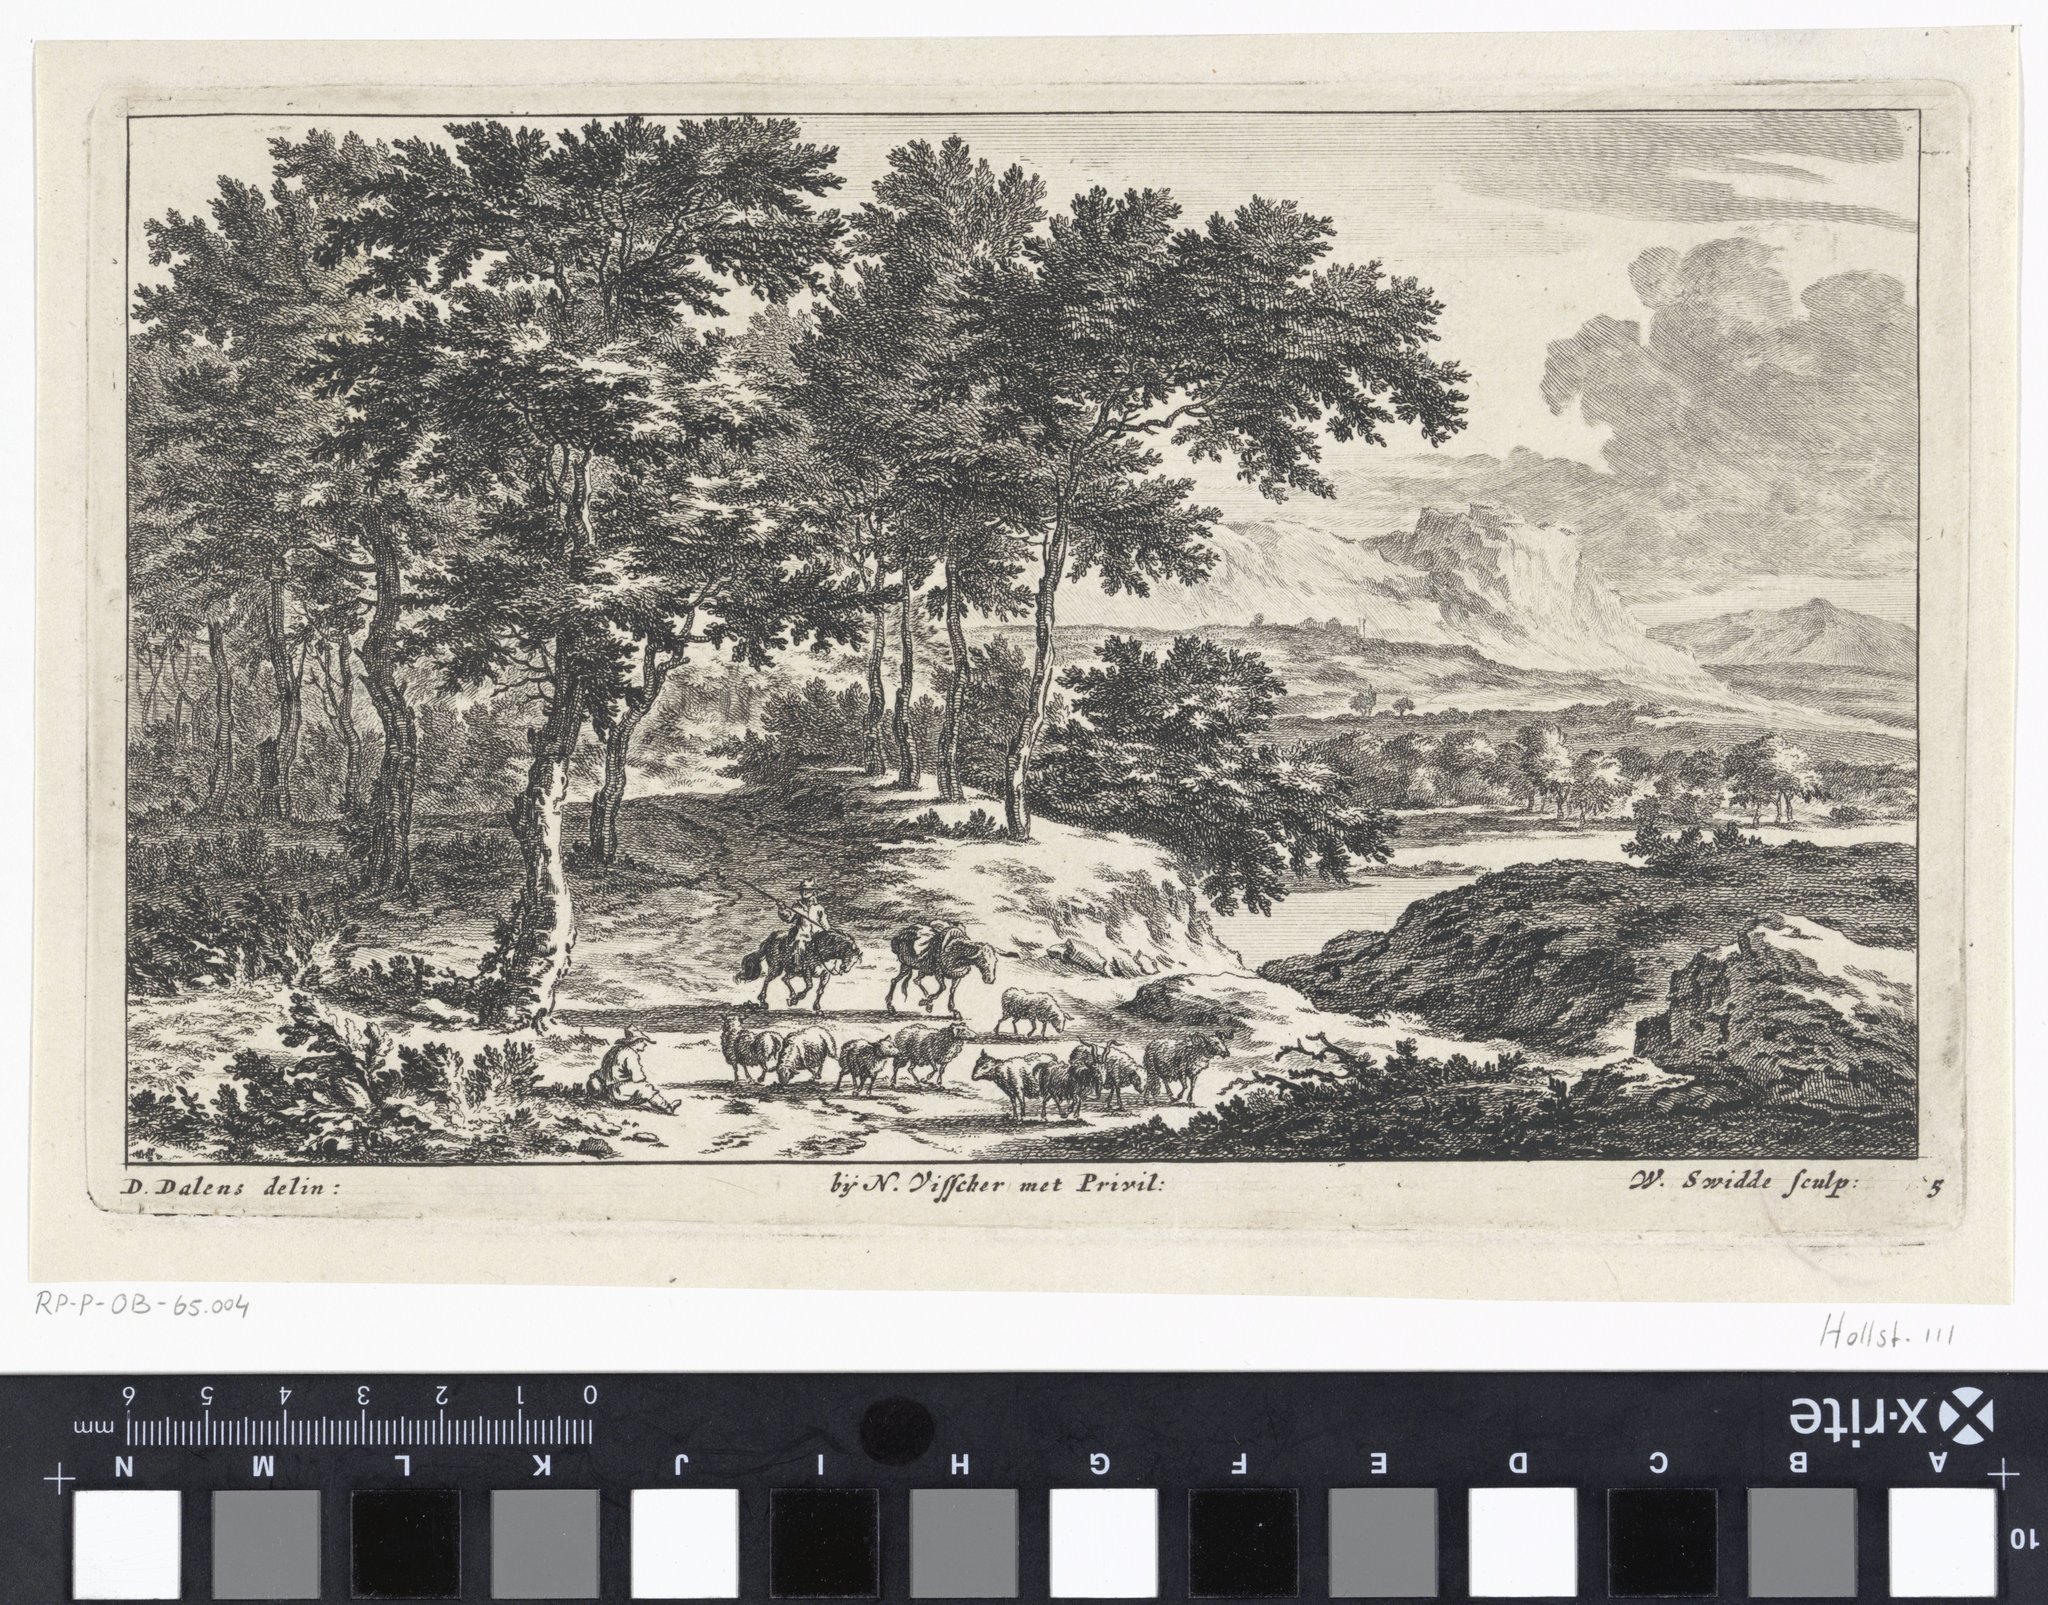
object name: print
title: Landschap met herder te paard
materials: paper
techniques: etching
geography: amsterdam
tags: river - hh - ideal landscapes, ass, donkey, herd, flock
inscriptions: collector's mark: Lugt 240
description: In een landschap met een rivier drijft een herder te paard een ezel voor zich uit. Op de voorgrond een kudde schapen.